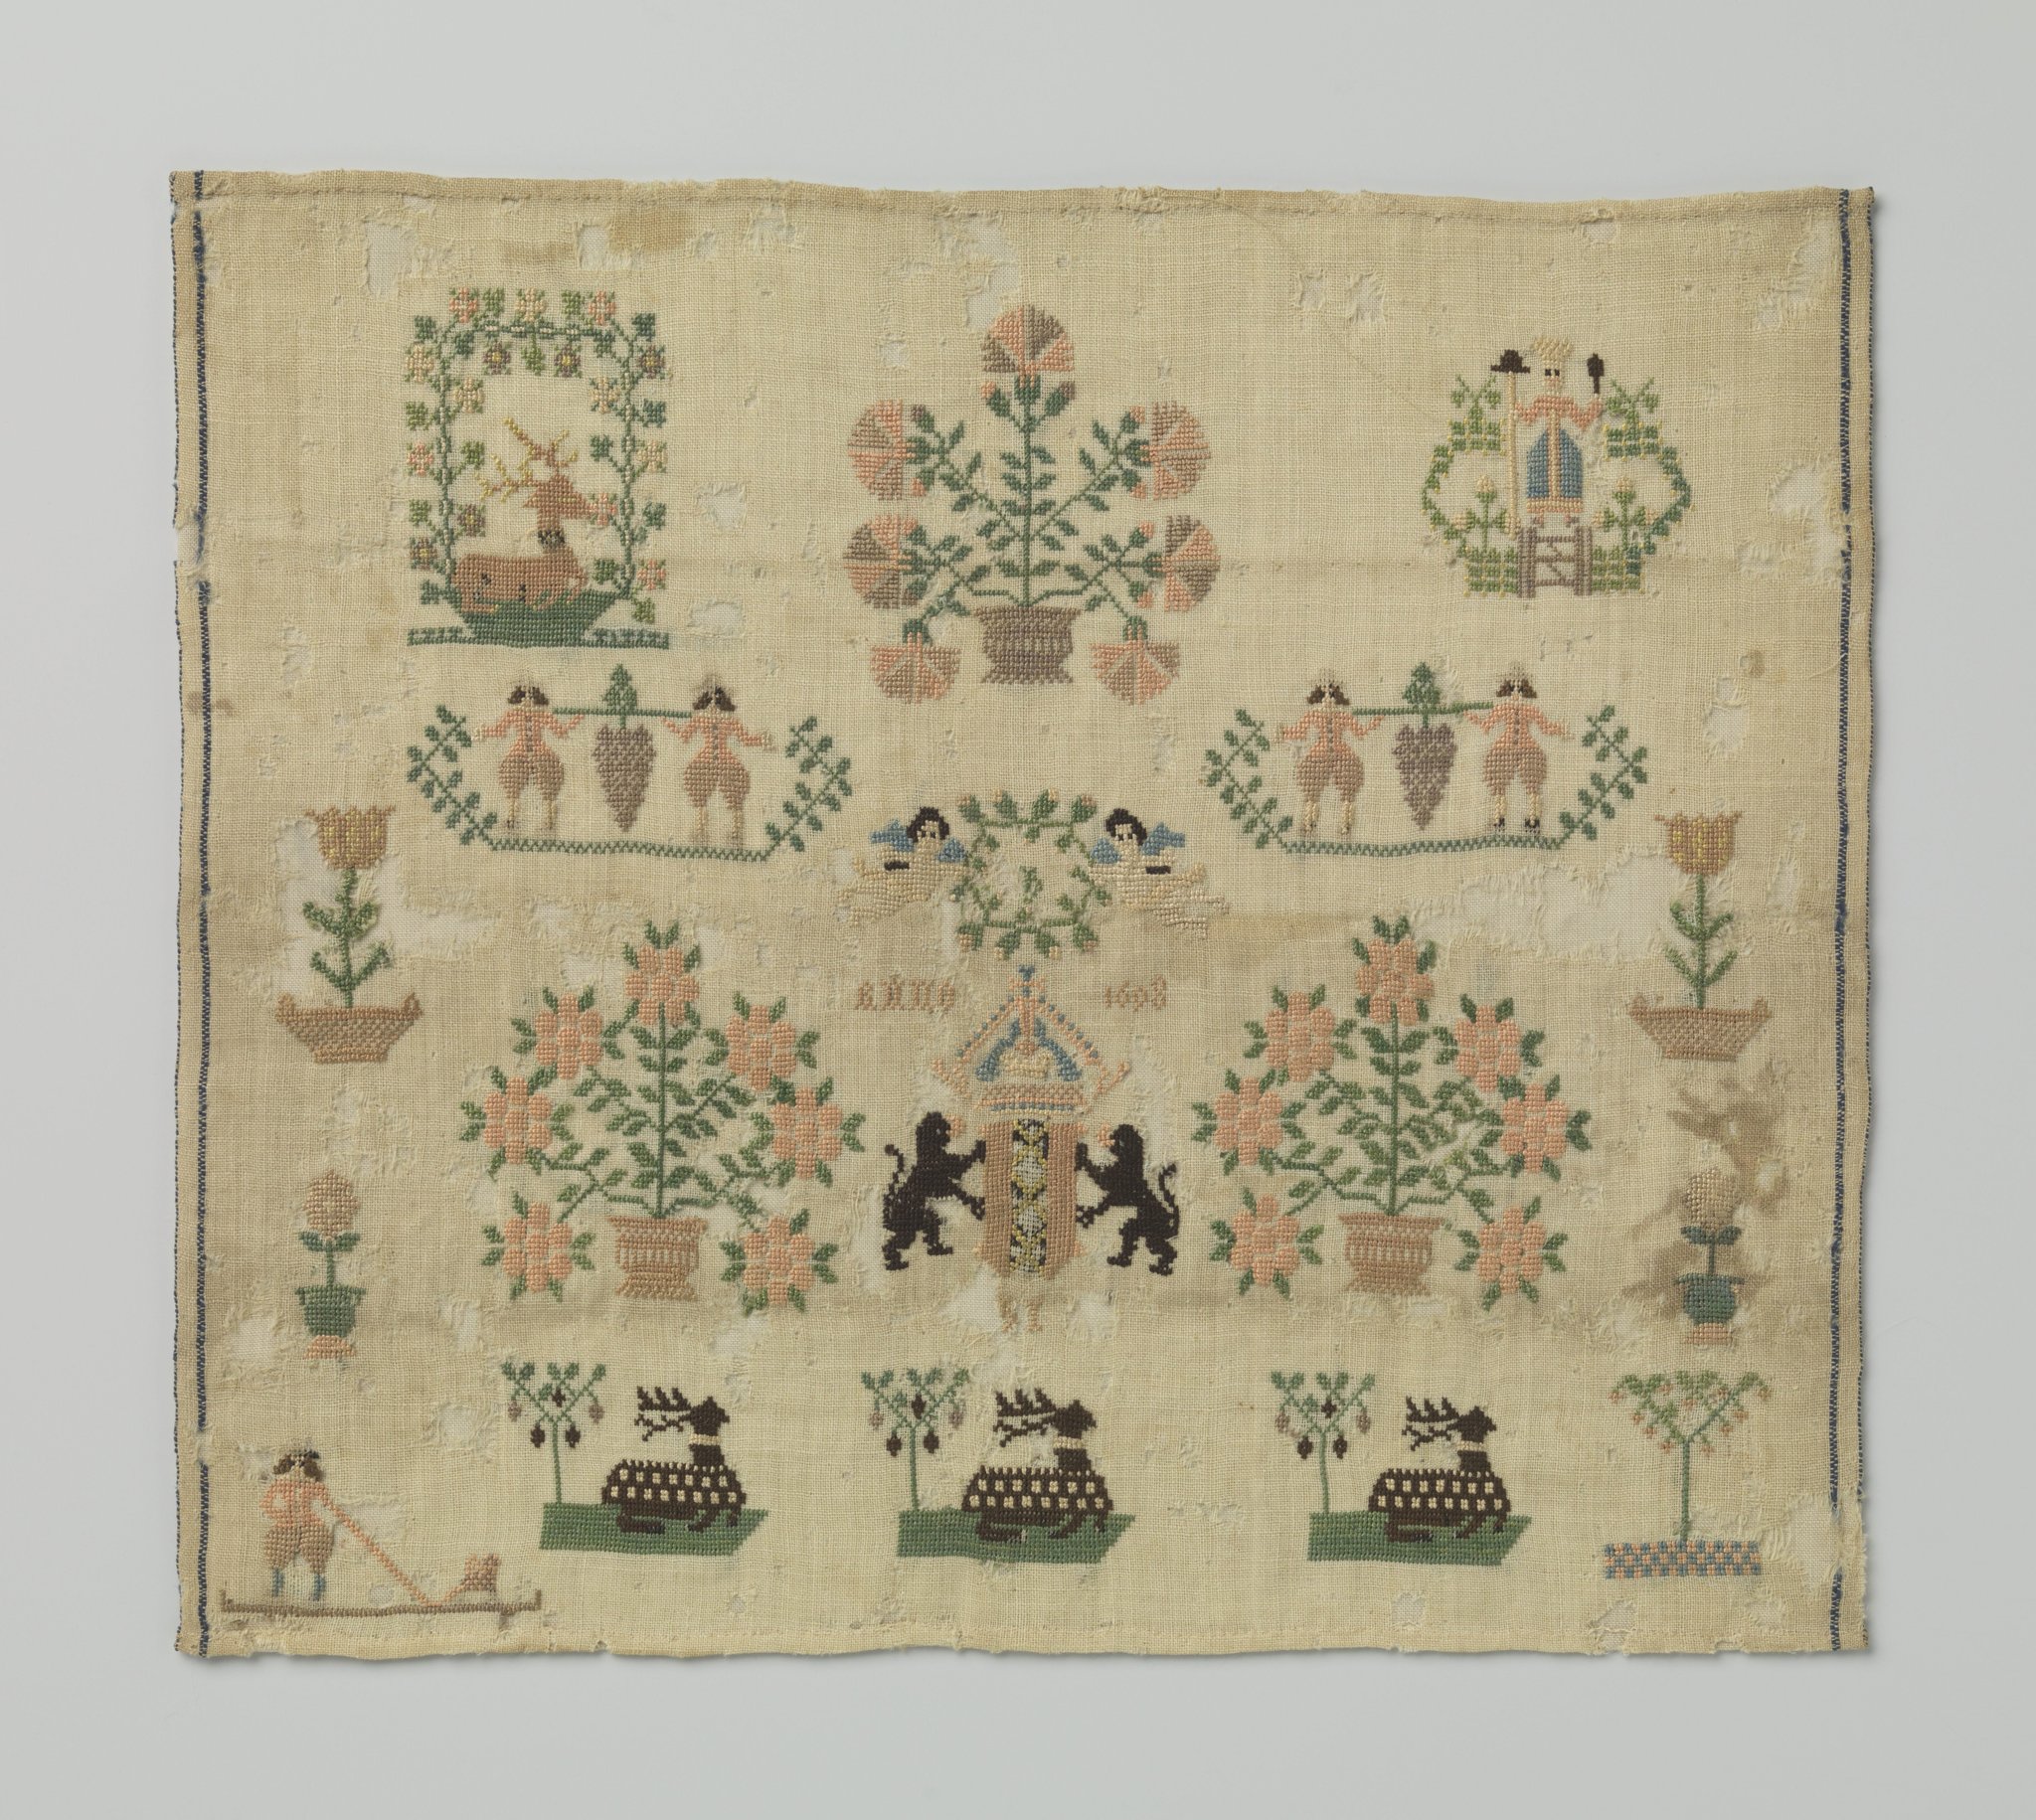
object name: merkdoek, merklap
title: Merklap van wollen mousseline waarop met kruissteken in zijde zijn geborduurd het wapen van Amsterdam, liggende damherten, Josef en Caleb met de vrucht van het land Kanaän, de Hollandse Maagd met vrijheidshoed in de Hollandse tuin, ANNO 1698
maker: Anonymous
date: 1698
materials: silk, wool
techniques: embroidered, weave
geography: amsterdam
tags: kanaän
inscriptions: date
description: Op een wollen mousseline ondergrond (vergeeld) het wapen van Amsterdam met bovenschrift ANNO 1698. Beneden een rij liggende damherten, boven Josef en Caleb met de vrucht van 't land Kanaän, rechts boven een vrouw met vrijheidshoed in de besloten tuin. H.I. onder wapen van Amsterdam: initialen van de maakster. Het hert in een mandje links boven verwijst naar een bijbelconnotatie. Gekleurde zelfkant aan beide zijden: weefbreedte 33.0 cm.